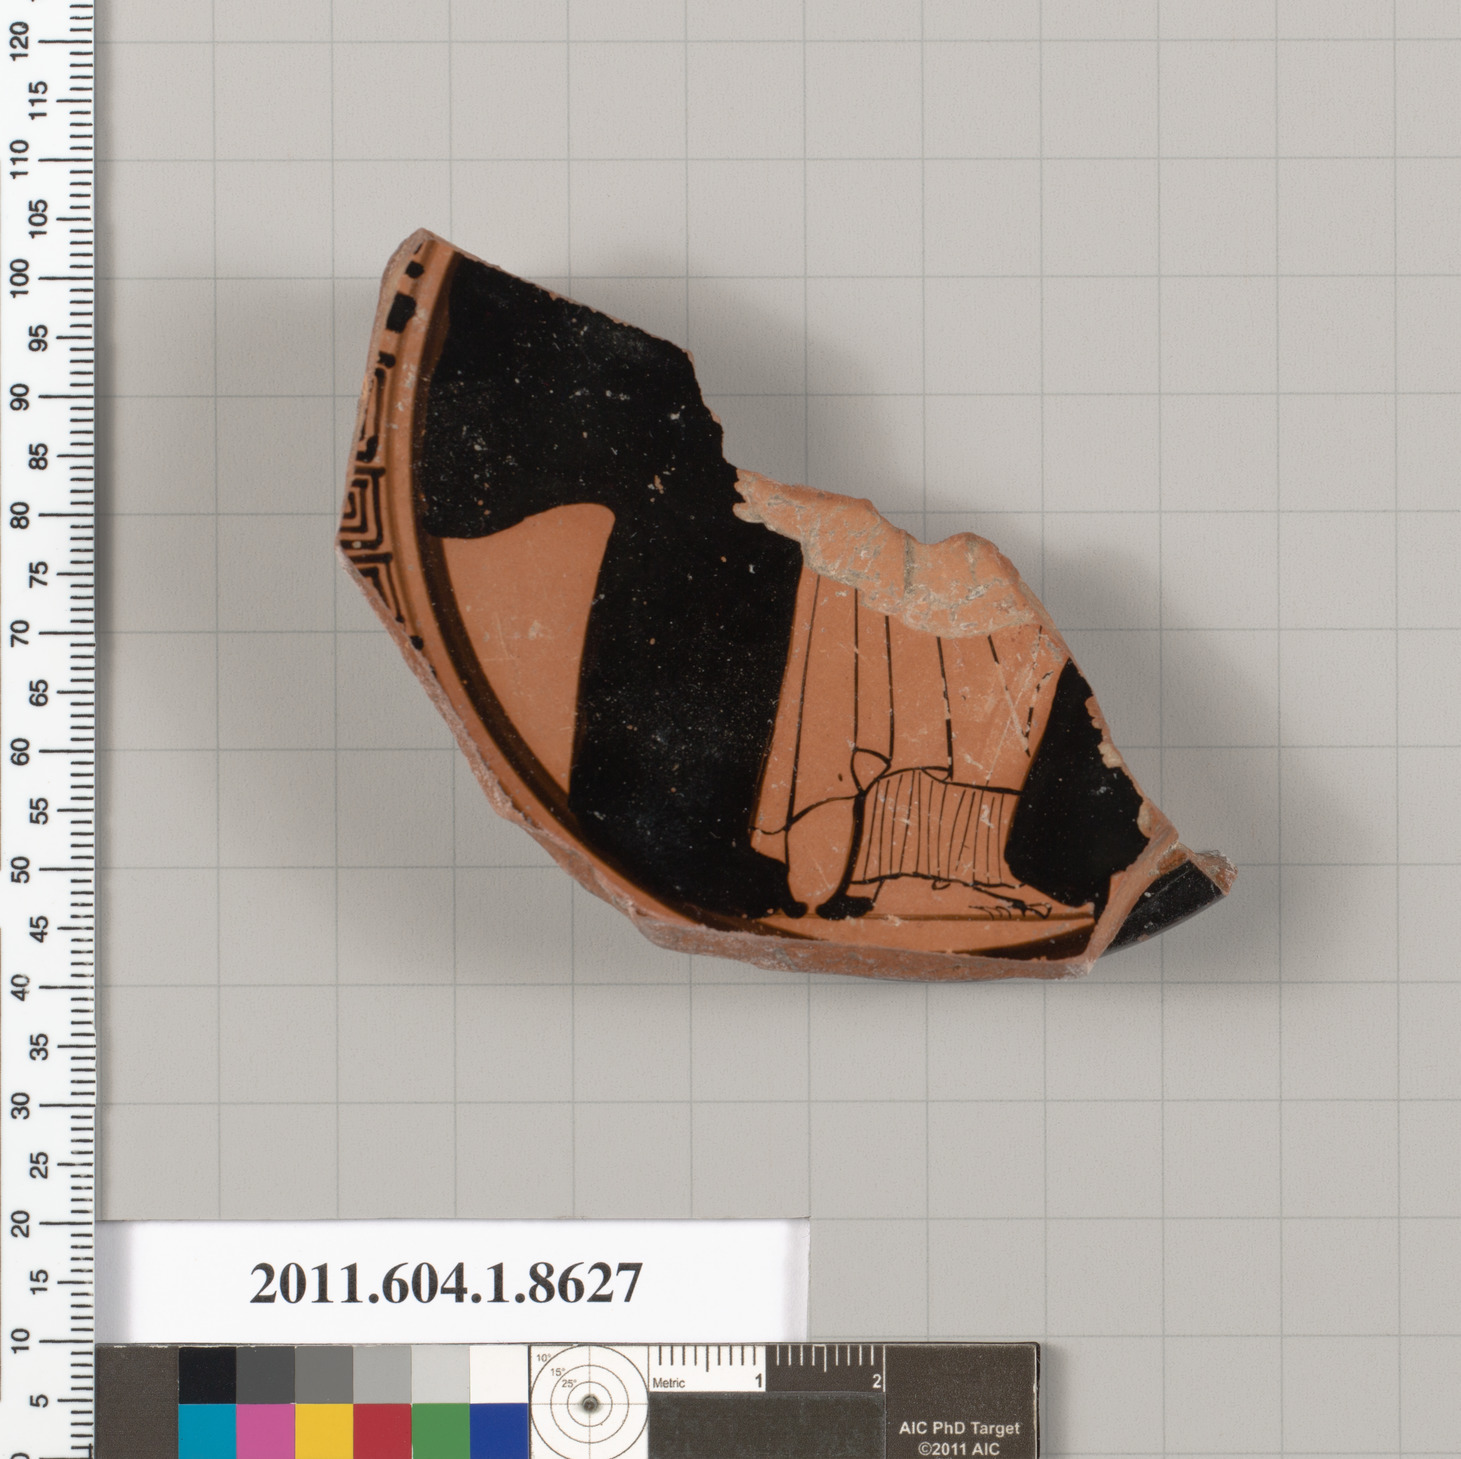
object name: kylix fragment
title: Terracotta fragment of a stemless kylix (drinking cup)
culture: greek, attic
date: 460-450 BCE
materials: terracotta